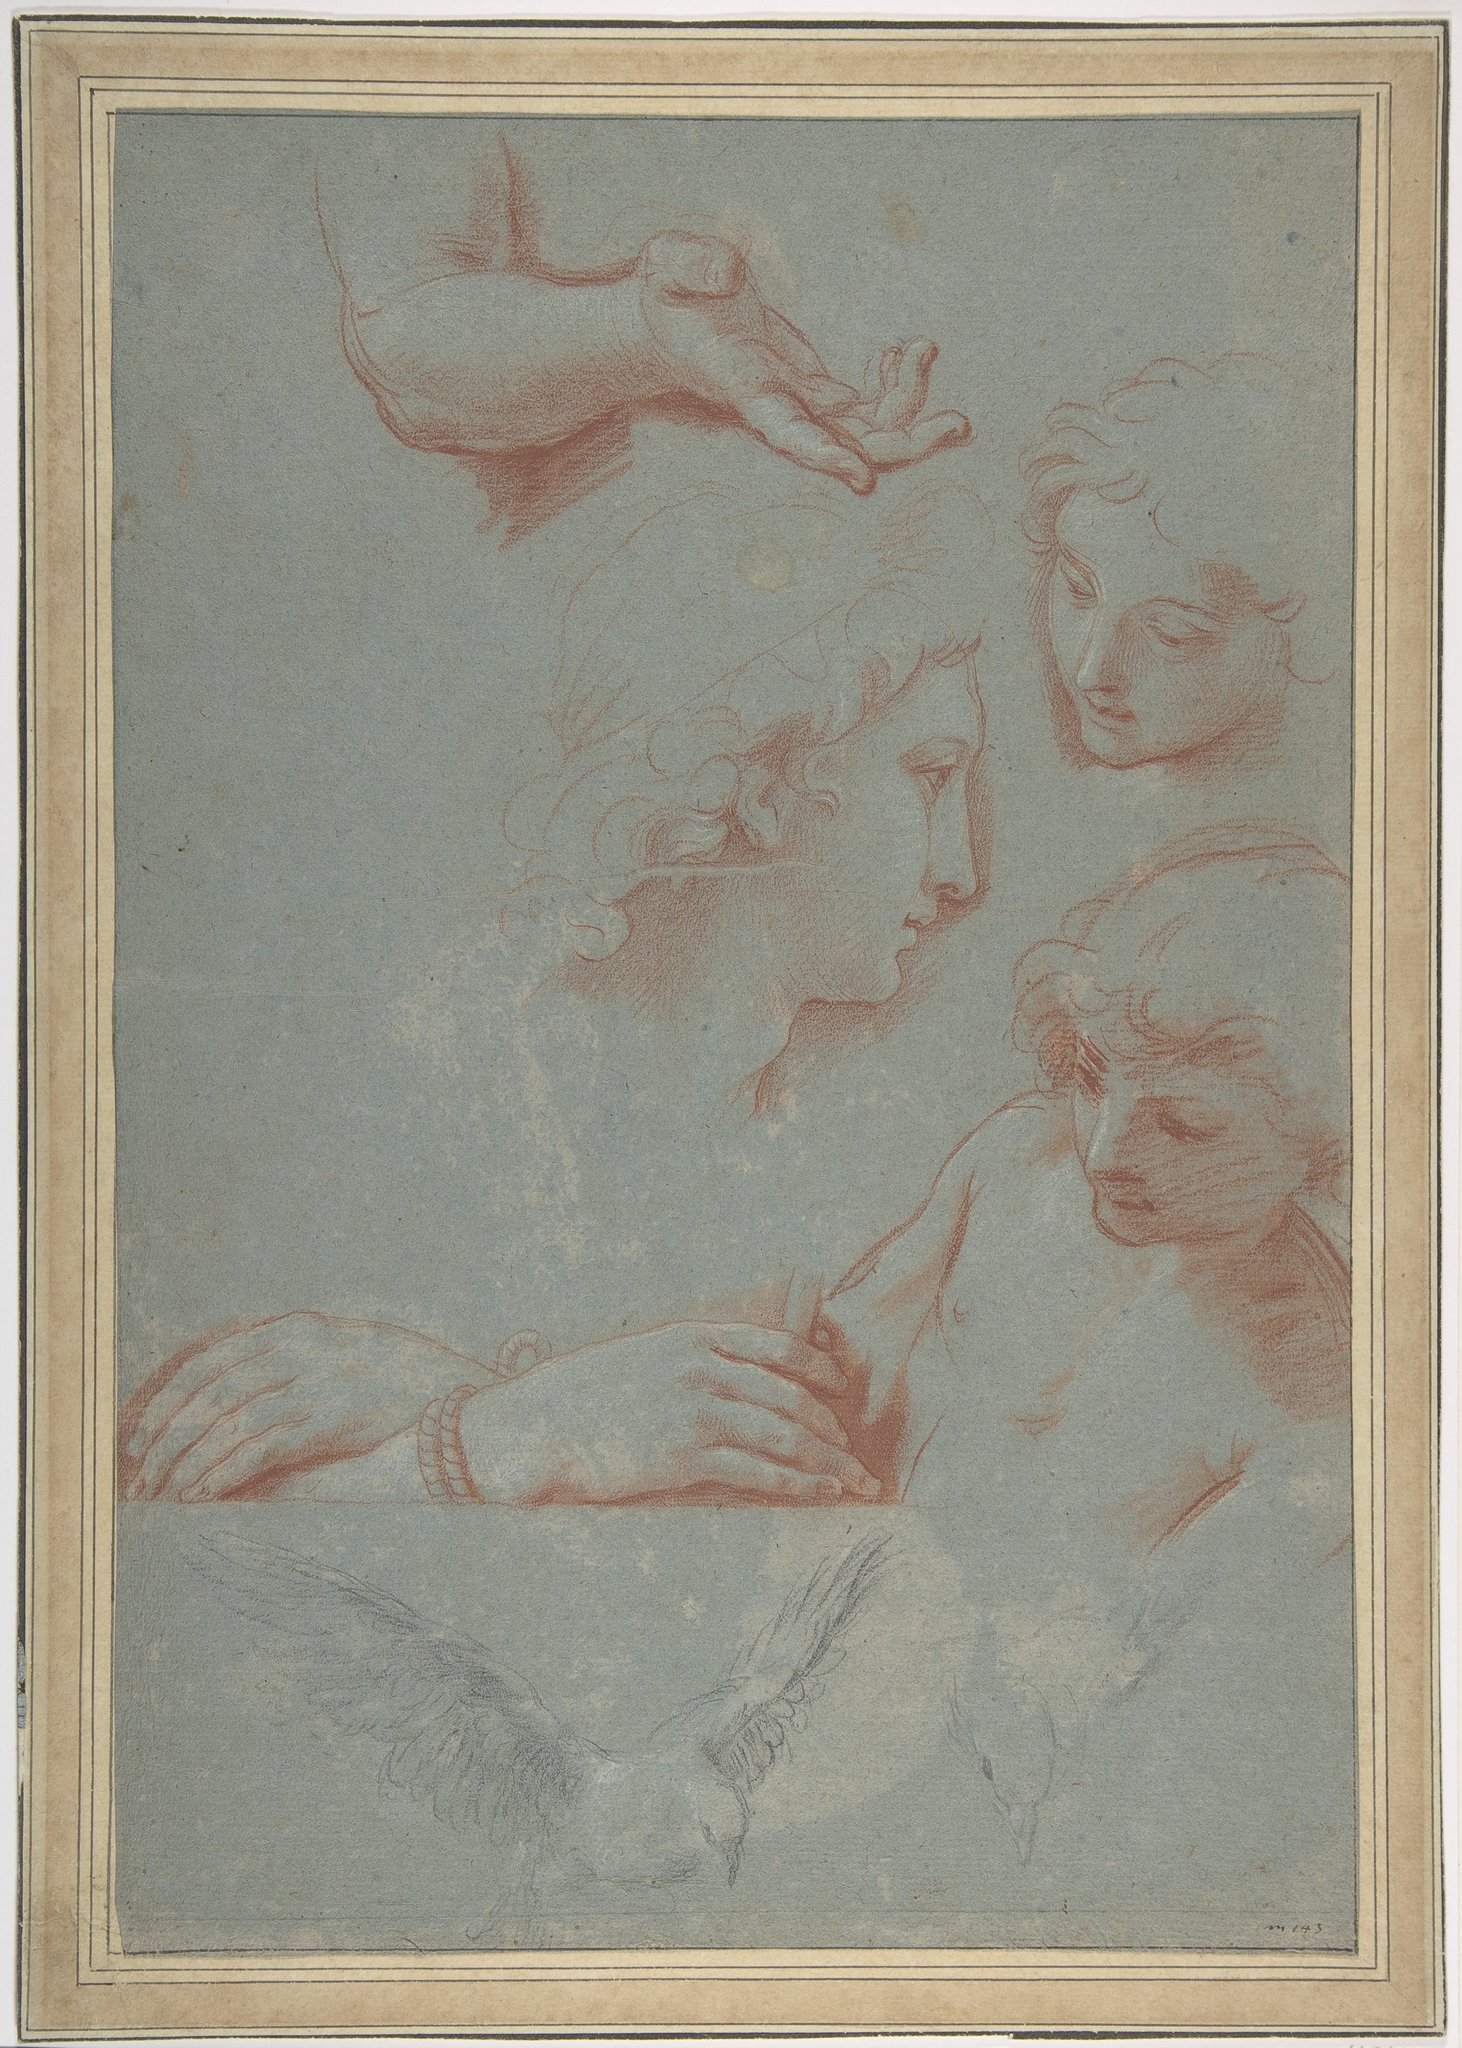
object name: drawing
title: Sheet of Studies: Heads, Hands, and Doves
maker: luigi garzi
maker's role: artist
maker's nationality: italian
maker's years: 1638-1721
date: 1638-1721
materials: chalk, paper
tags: doves,hands,heads